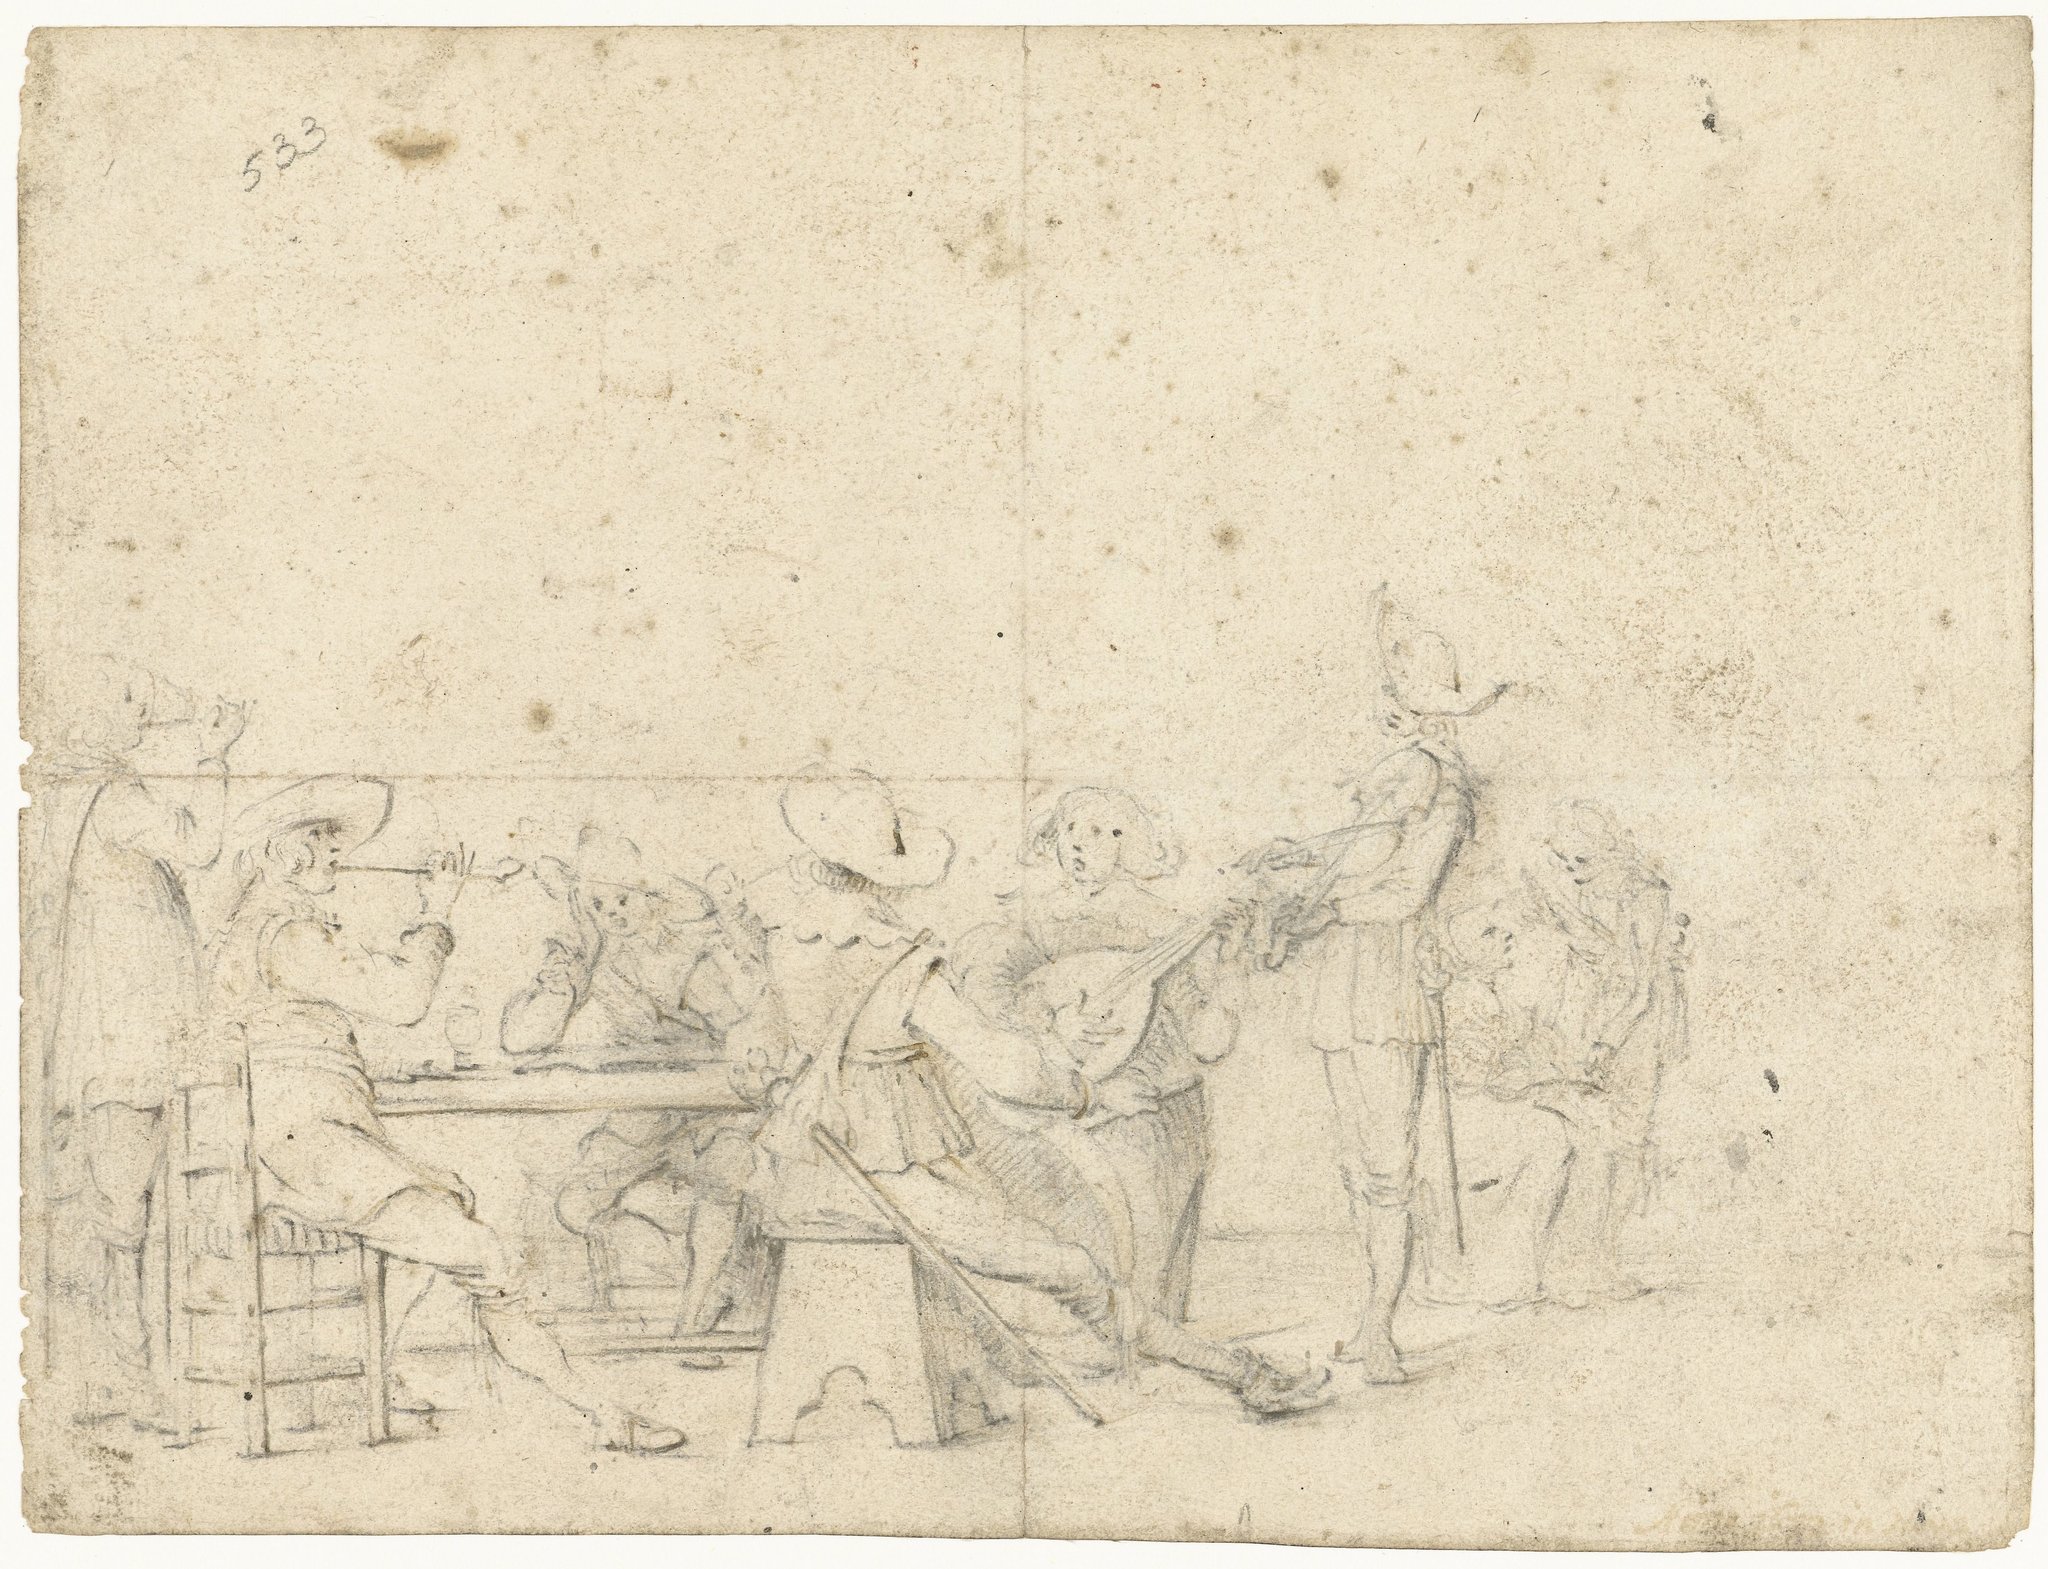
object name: drawing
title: Gezelschap van drinkende, rokende en musicerende jongelui rond een tafel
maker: gerard ter borch (ii)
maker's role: draughtsman, painter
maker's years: 1617-1681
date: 1611-1632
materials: ink, paper, pencil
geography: zwolle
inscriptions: date: ‘Anno 1632 in (?) November’